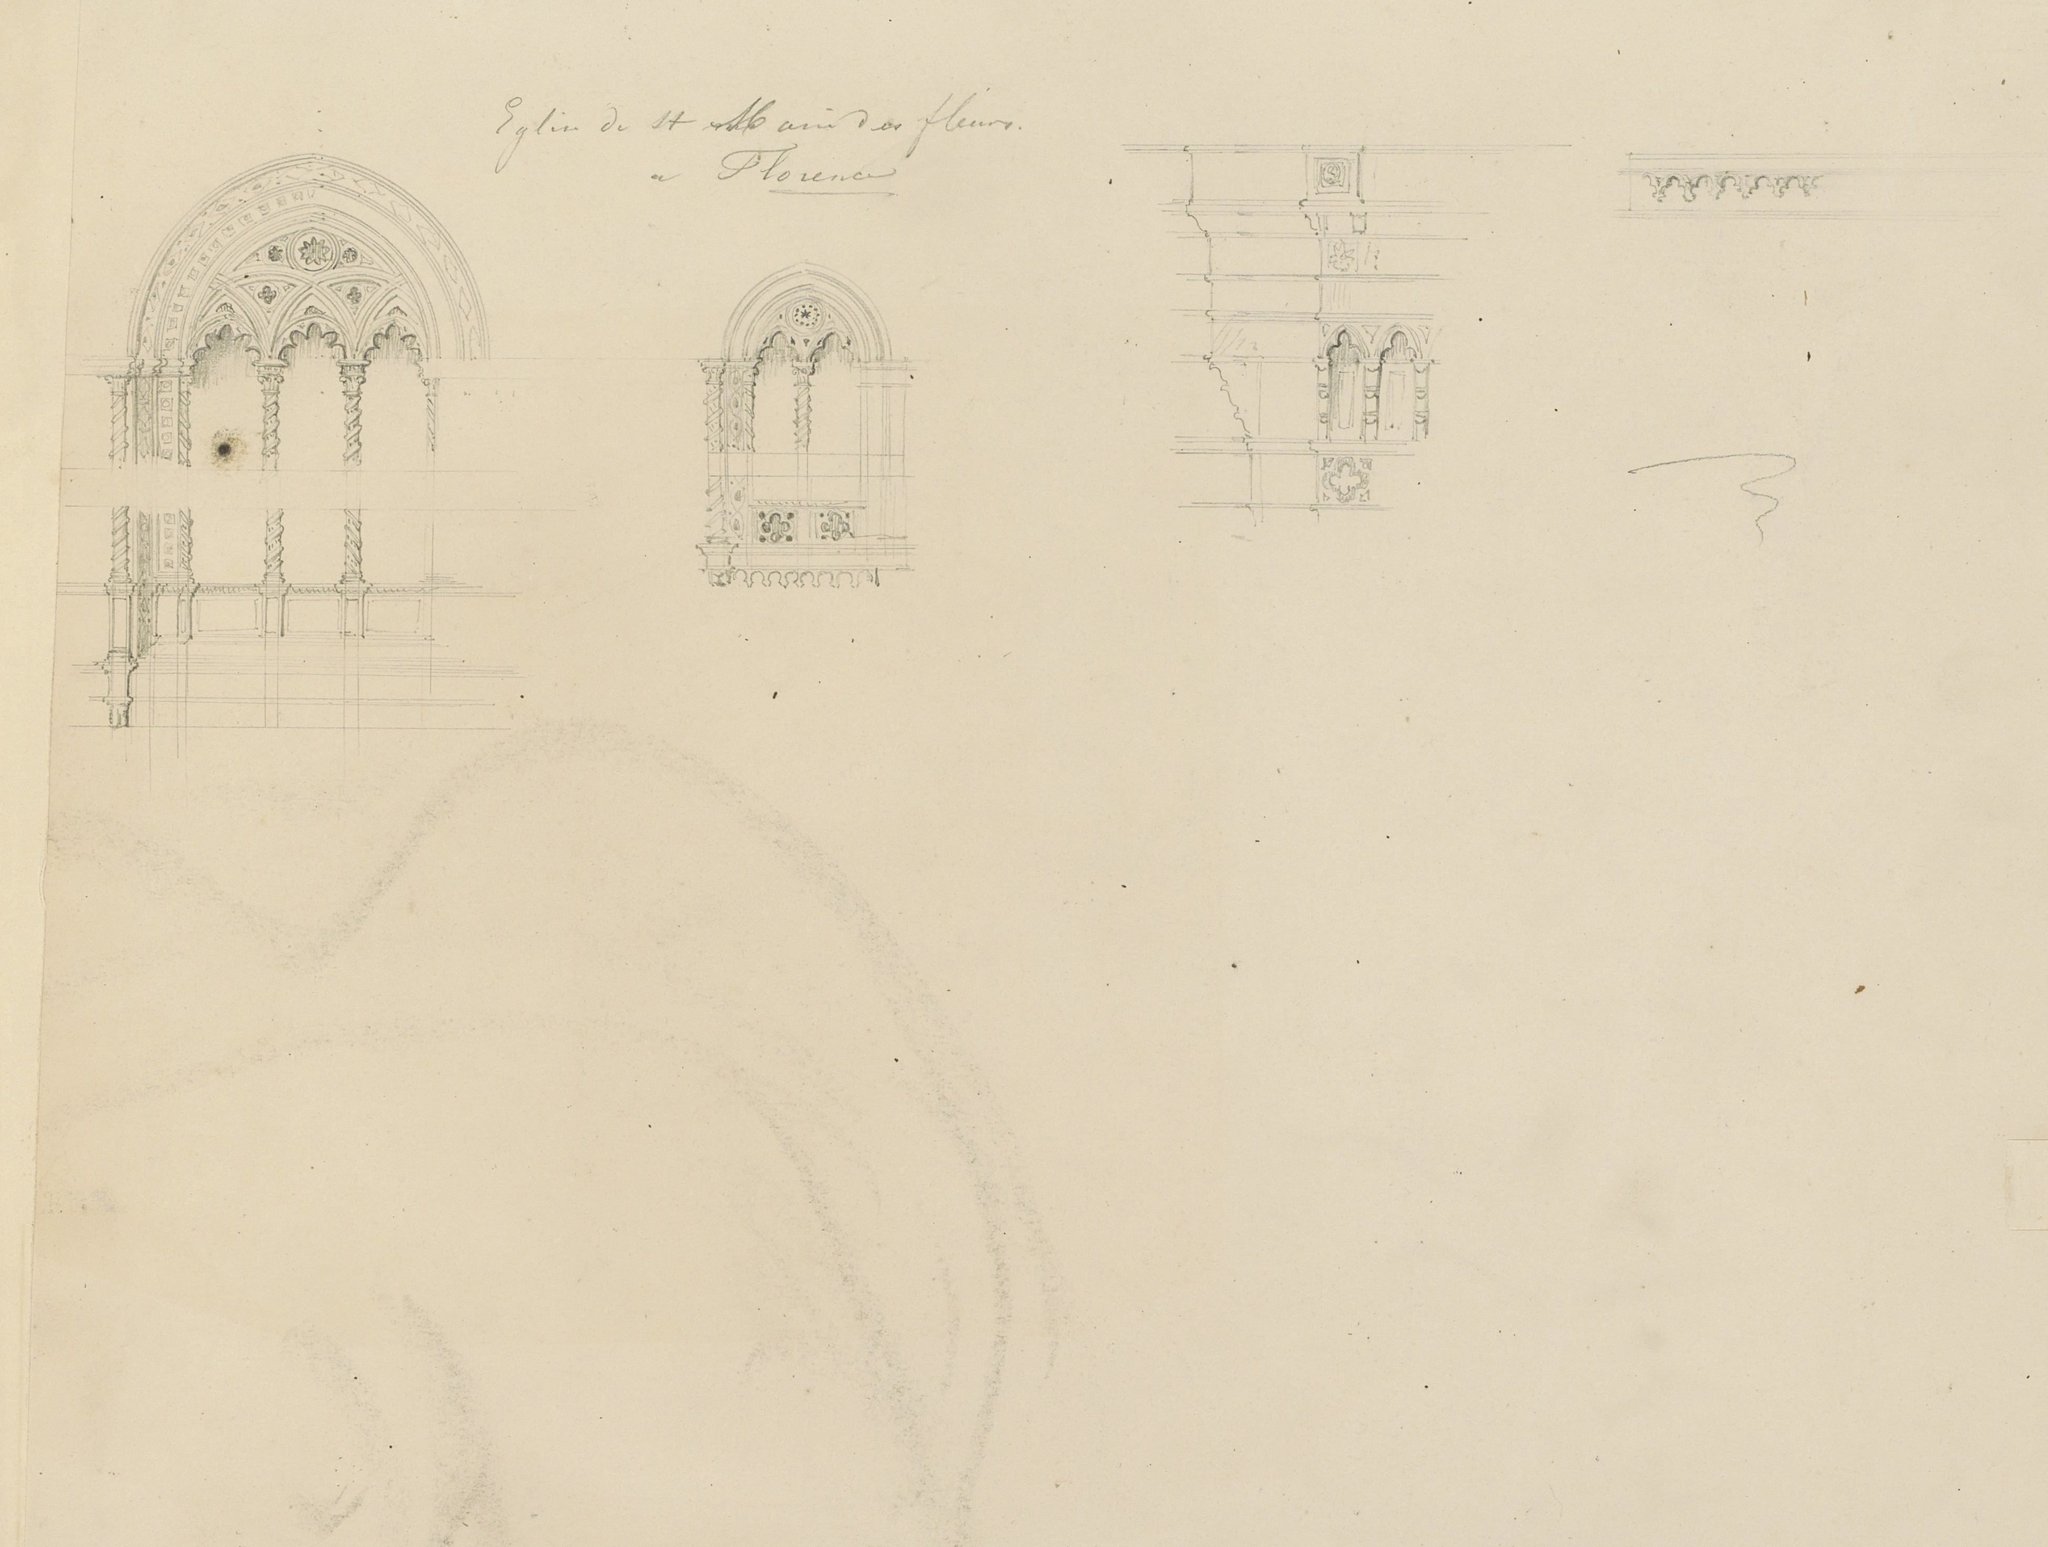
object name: sketchbook leaf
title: Details van gevel van de Dom van Florence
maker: pierre joseph hubert cuypers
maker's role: draughtsman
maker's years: 1827-1921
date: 1850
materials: paper, pencil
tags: exterior ~ representation of a building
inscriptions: annotation: ‘Eglise de St Marie des fleurs/ a Florence’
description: Blad 37 recto uit een schetsboek met 37 bladen.